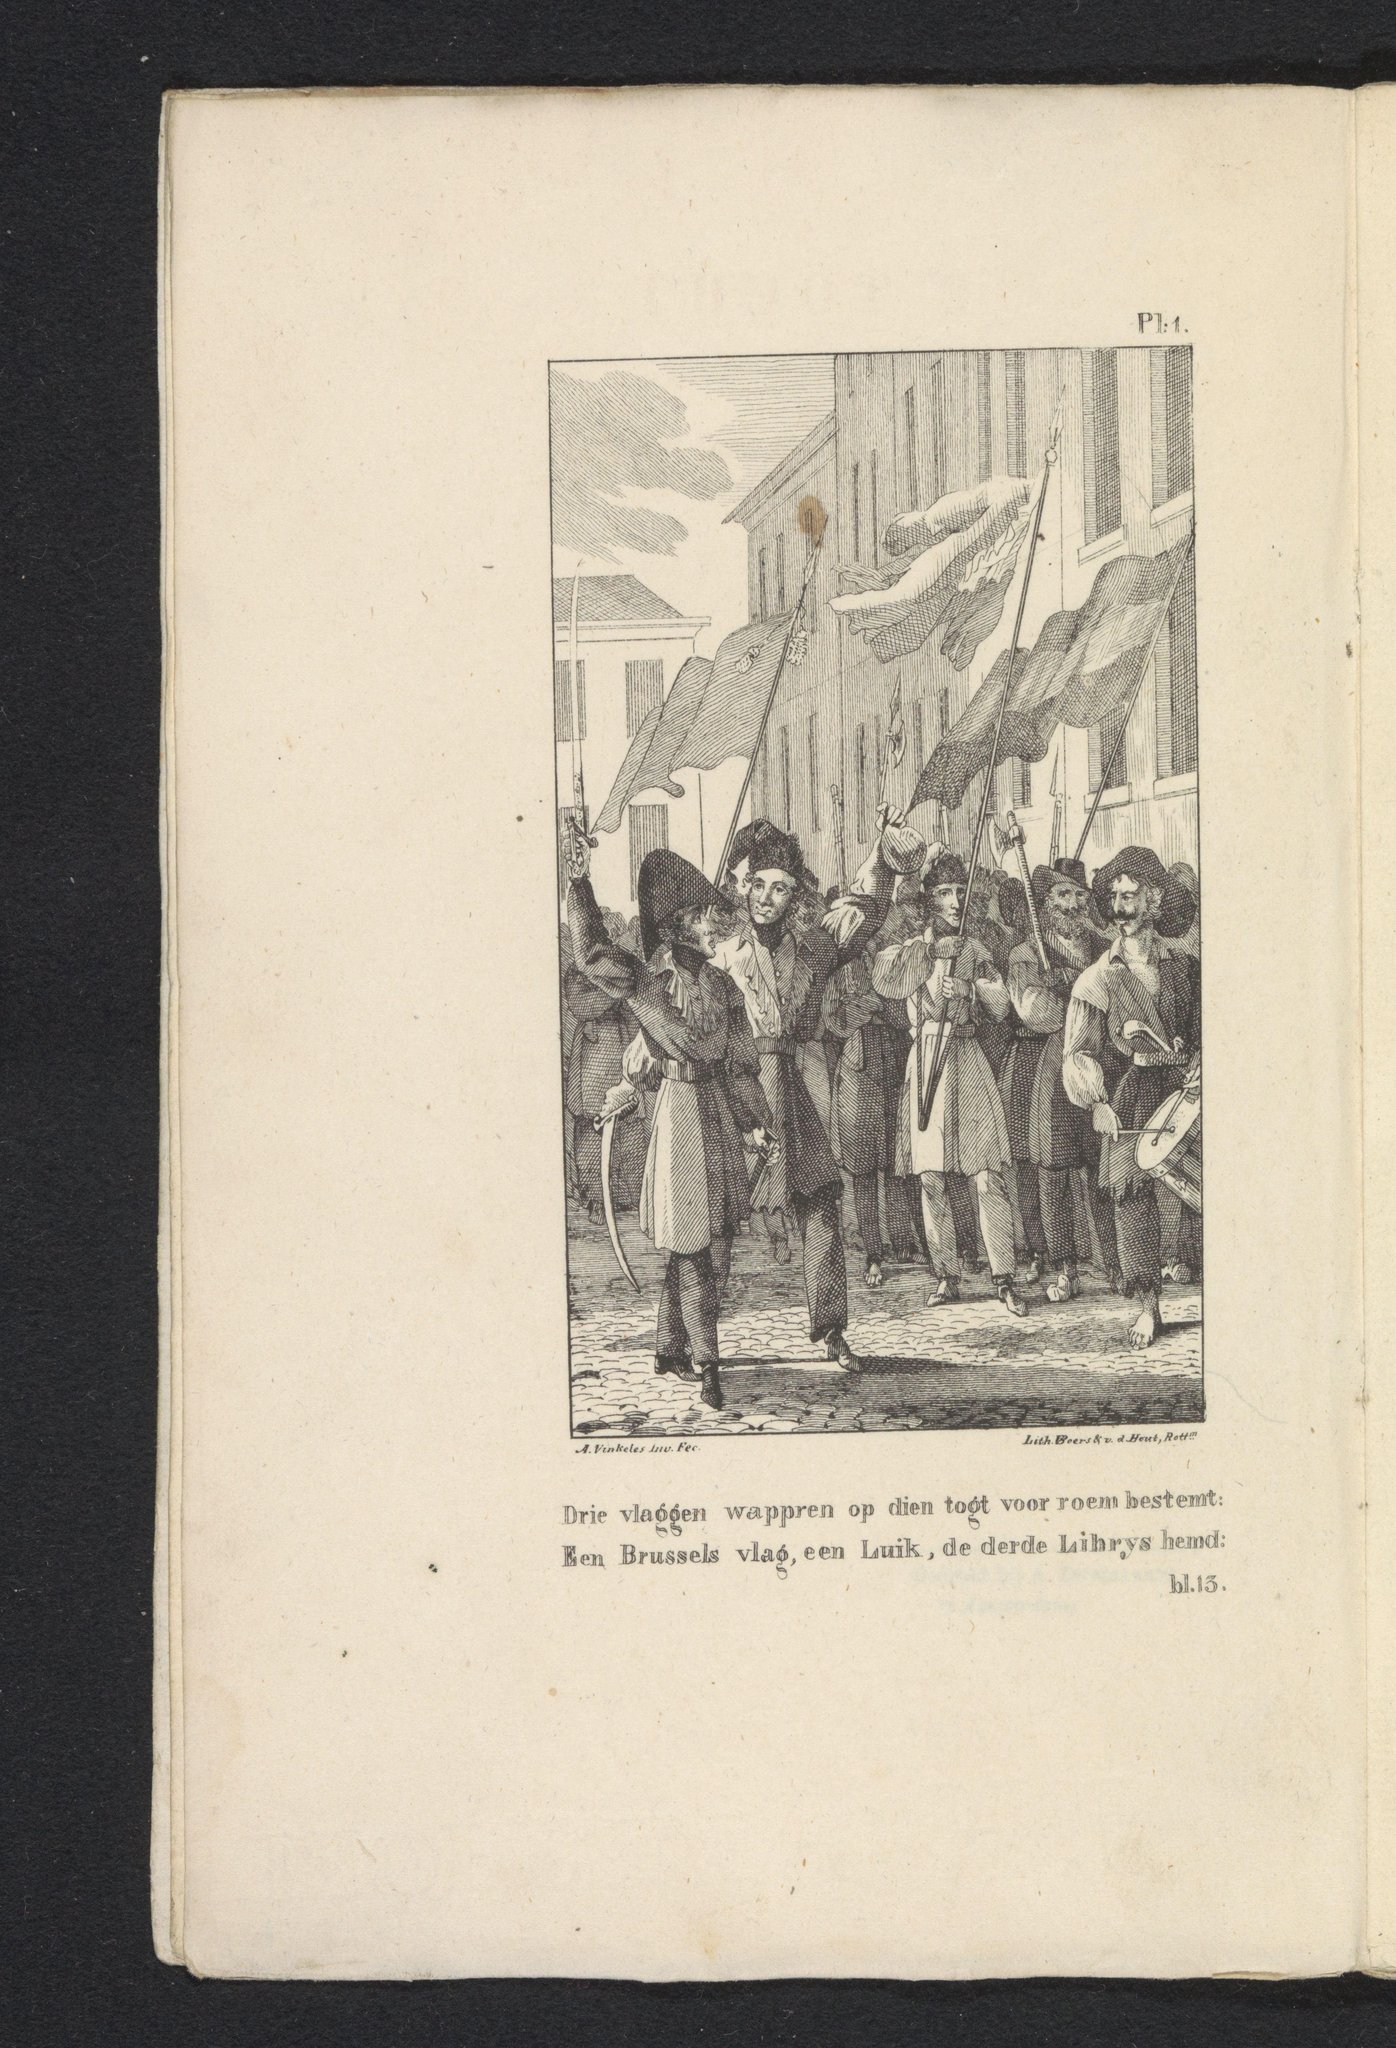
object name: cartoon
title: Drie vlaggen wappren op dien togt voor roem bestemt (...)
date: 1832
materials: paper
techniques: lithograph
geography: rotterdam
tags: flag, colours (as symbol of the state, etc.), liège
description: De groep Luikenaren met hun drie vaandels. Spotprent als illustratie in een heldenzang over de tocht van de tachtig Luikenaren naar Tervuren op 6 september 1830.